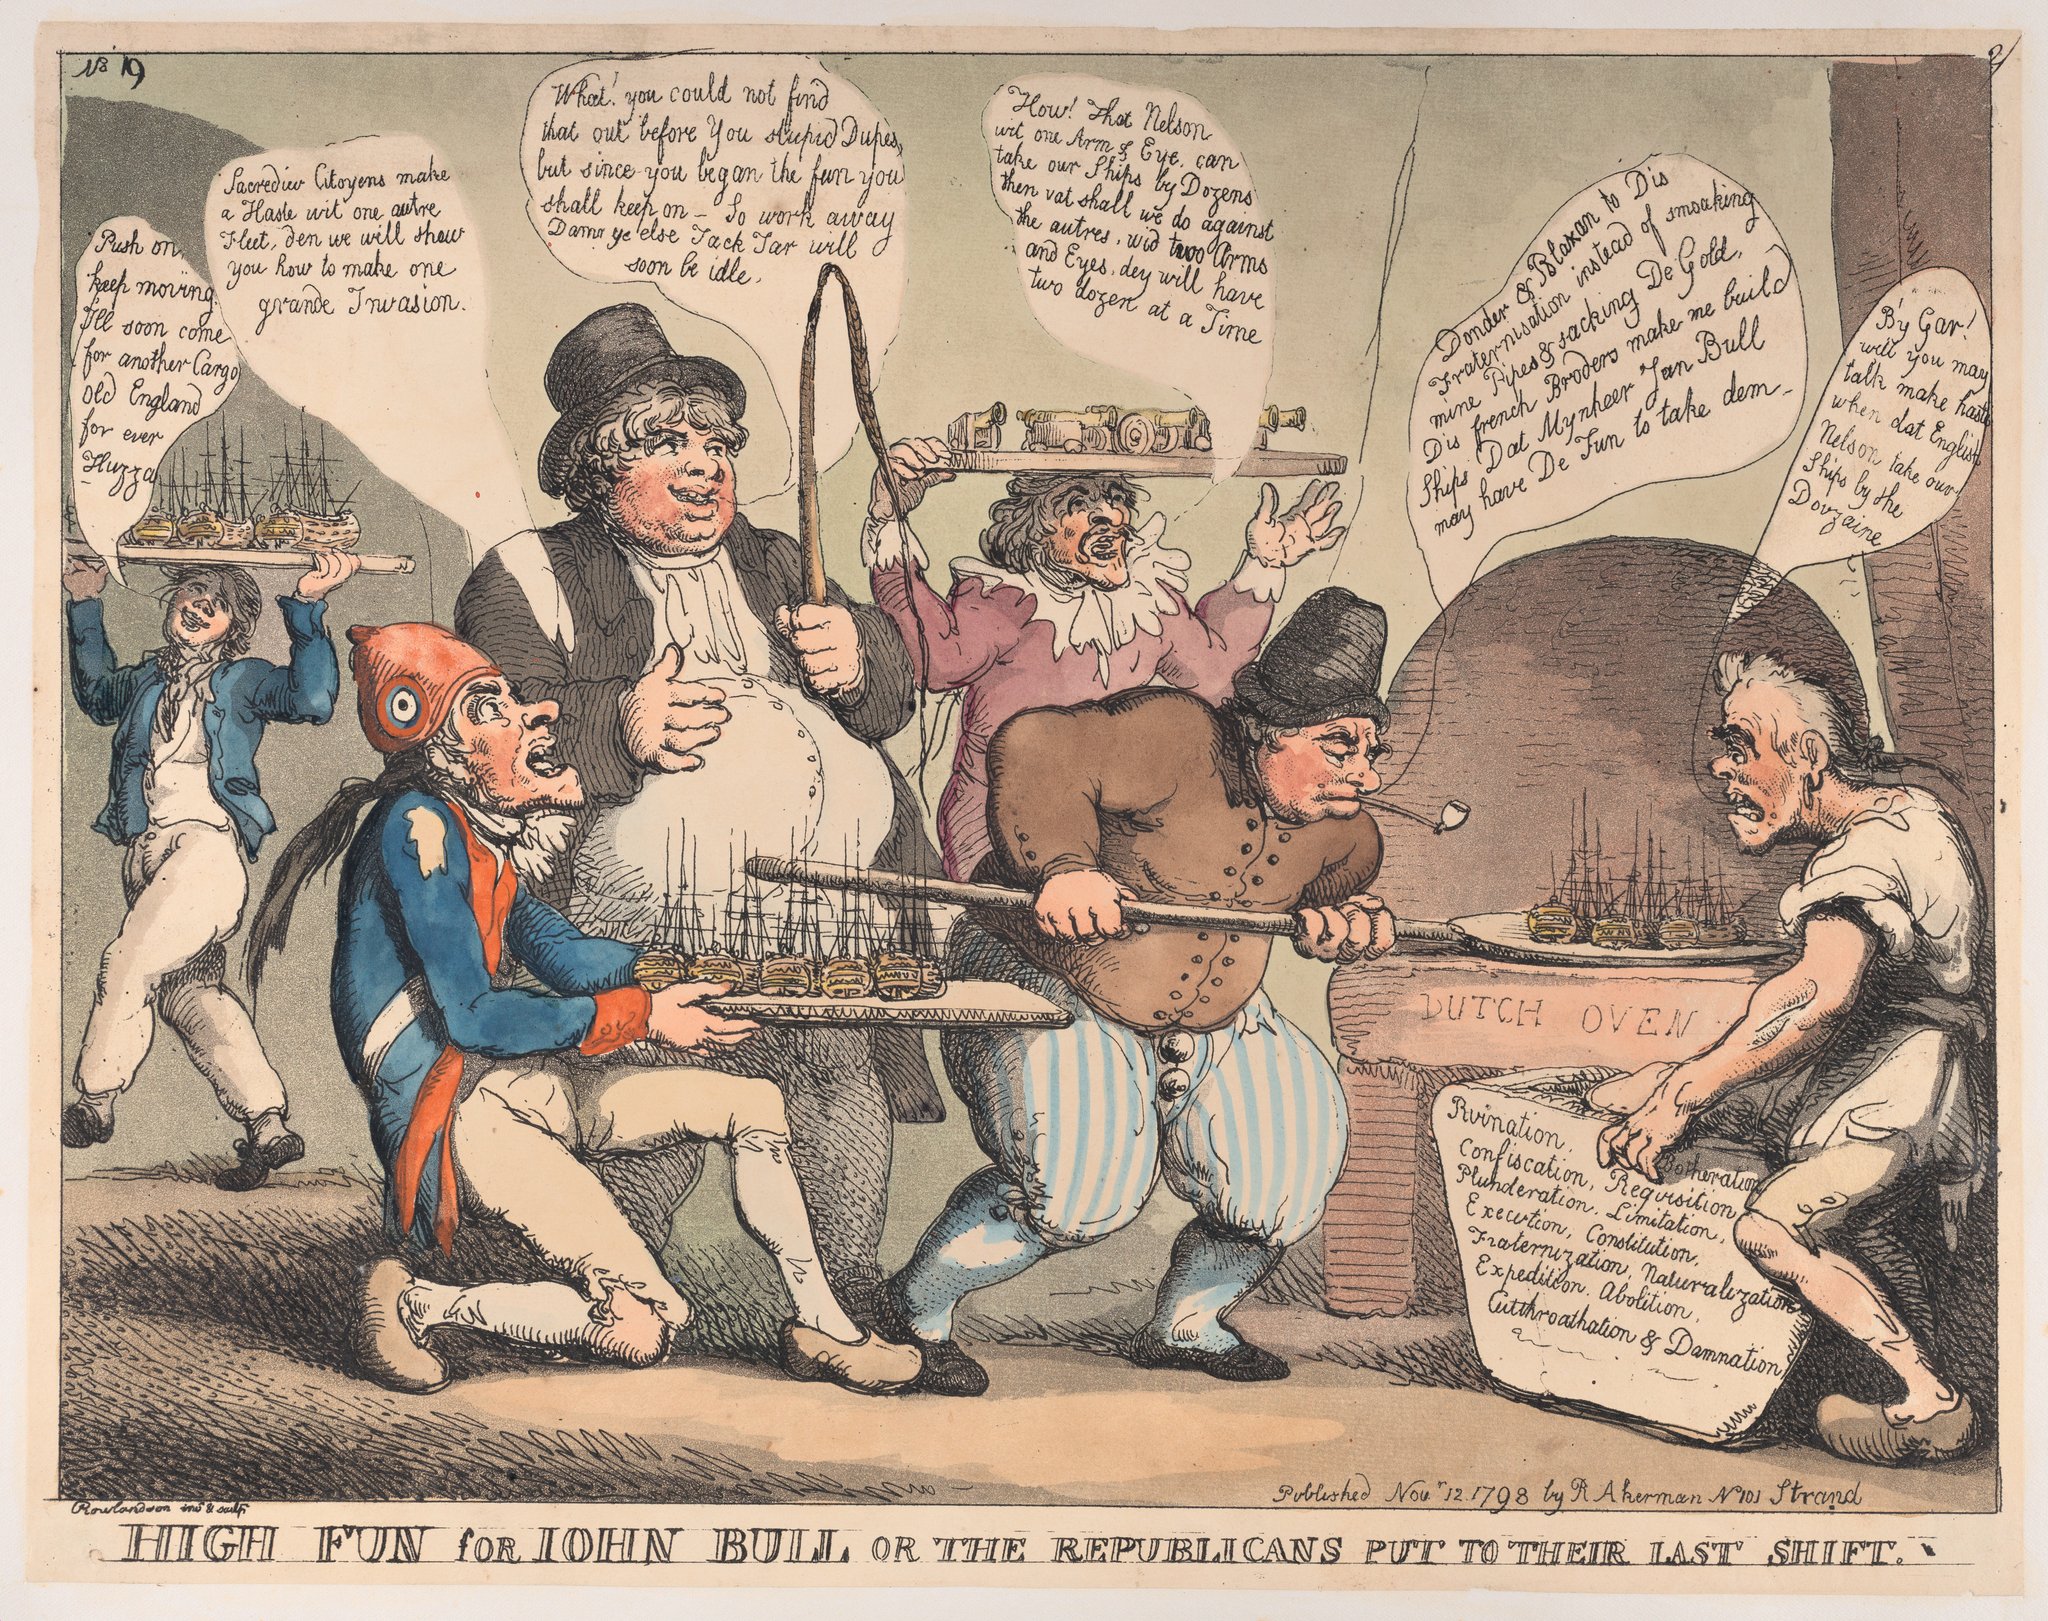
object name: print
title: High Fun for John Bull, or the Republicans Put to their Last Shift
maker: thomas rowlandson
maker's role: artist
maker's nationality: british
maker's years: 1757-1827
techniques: aquatint, etching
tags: satire,men,politics